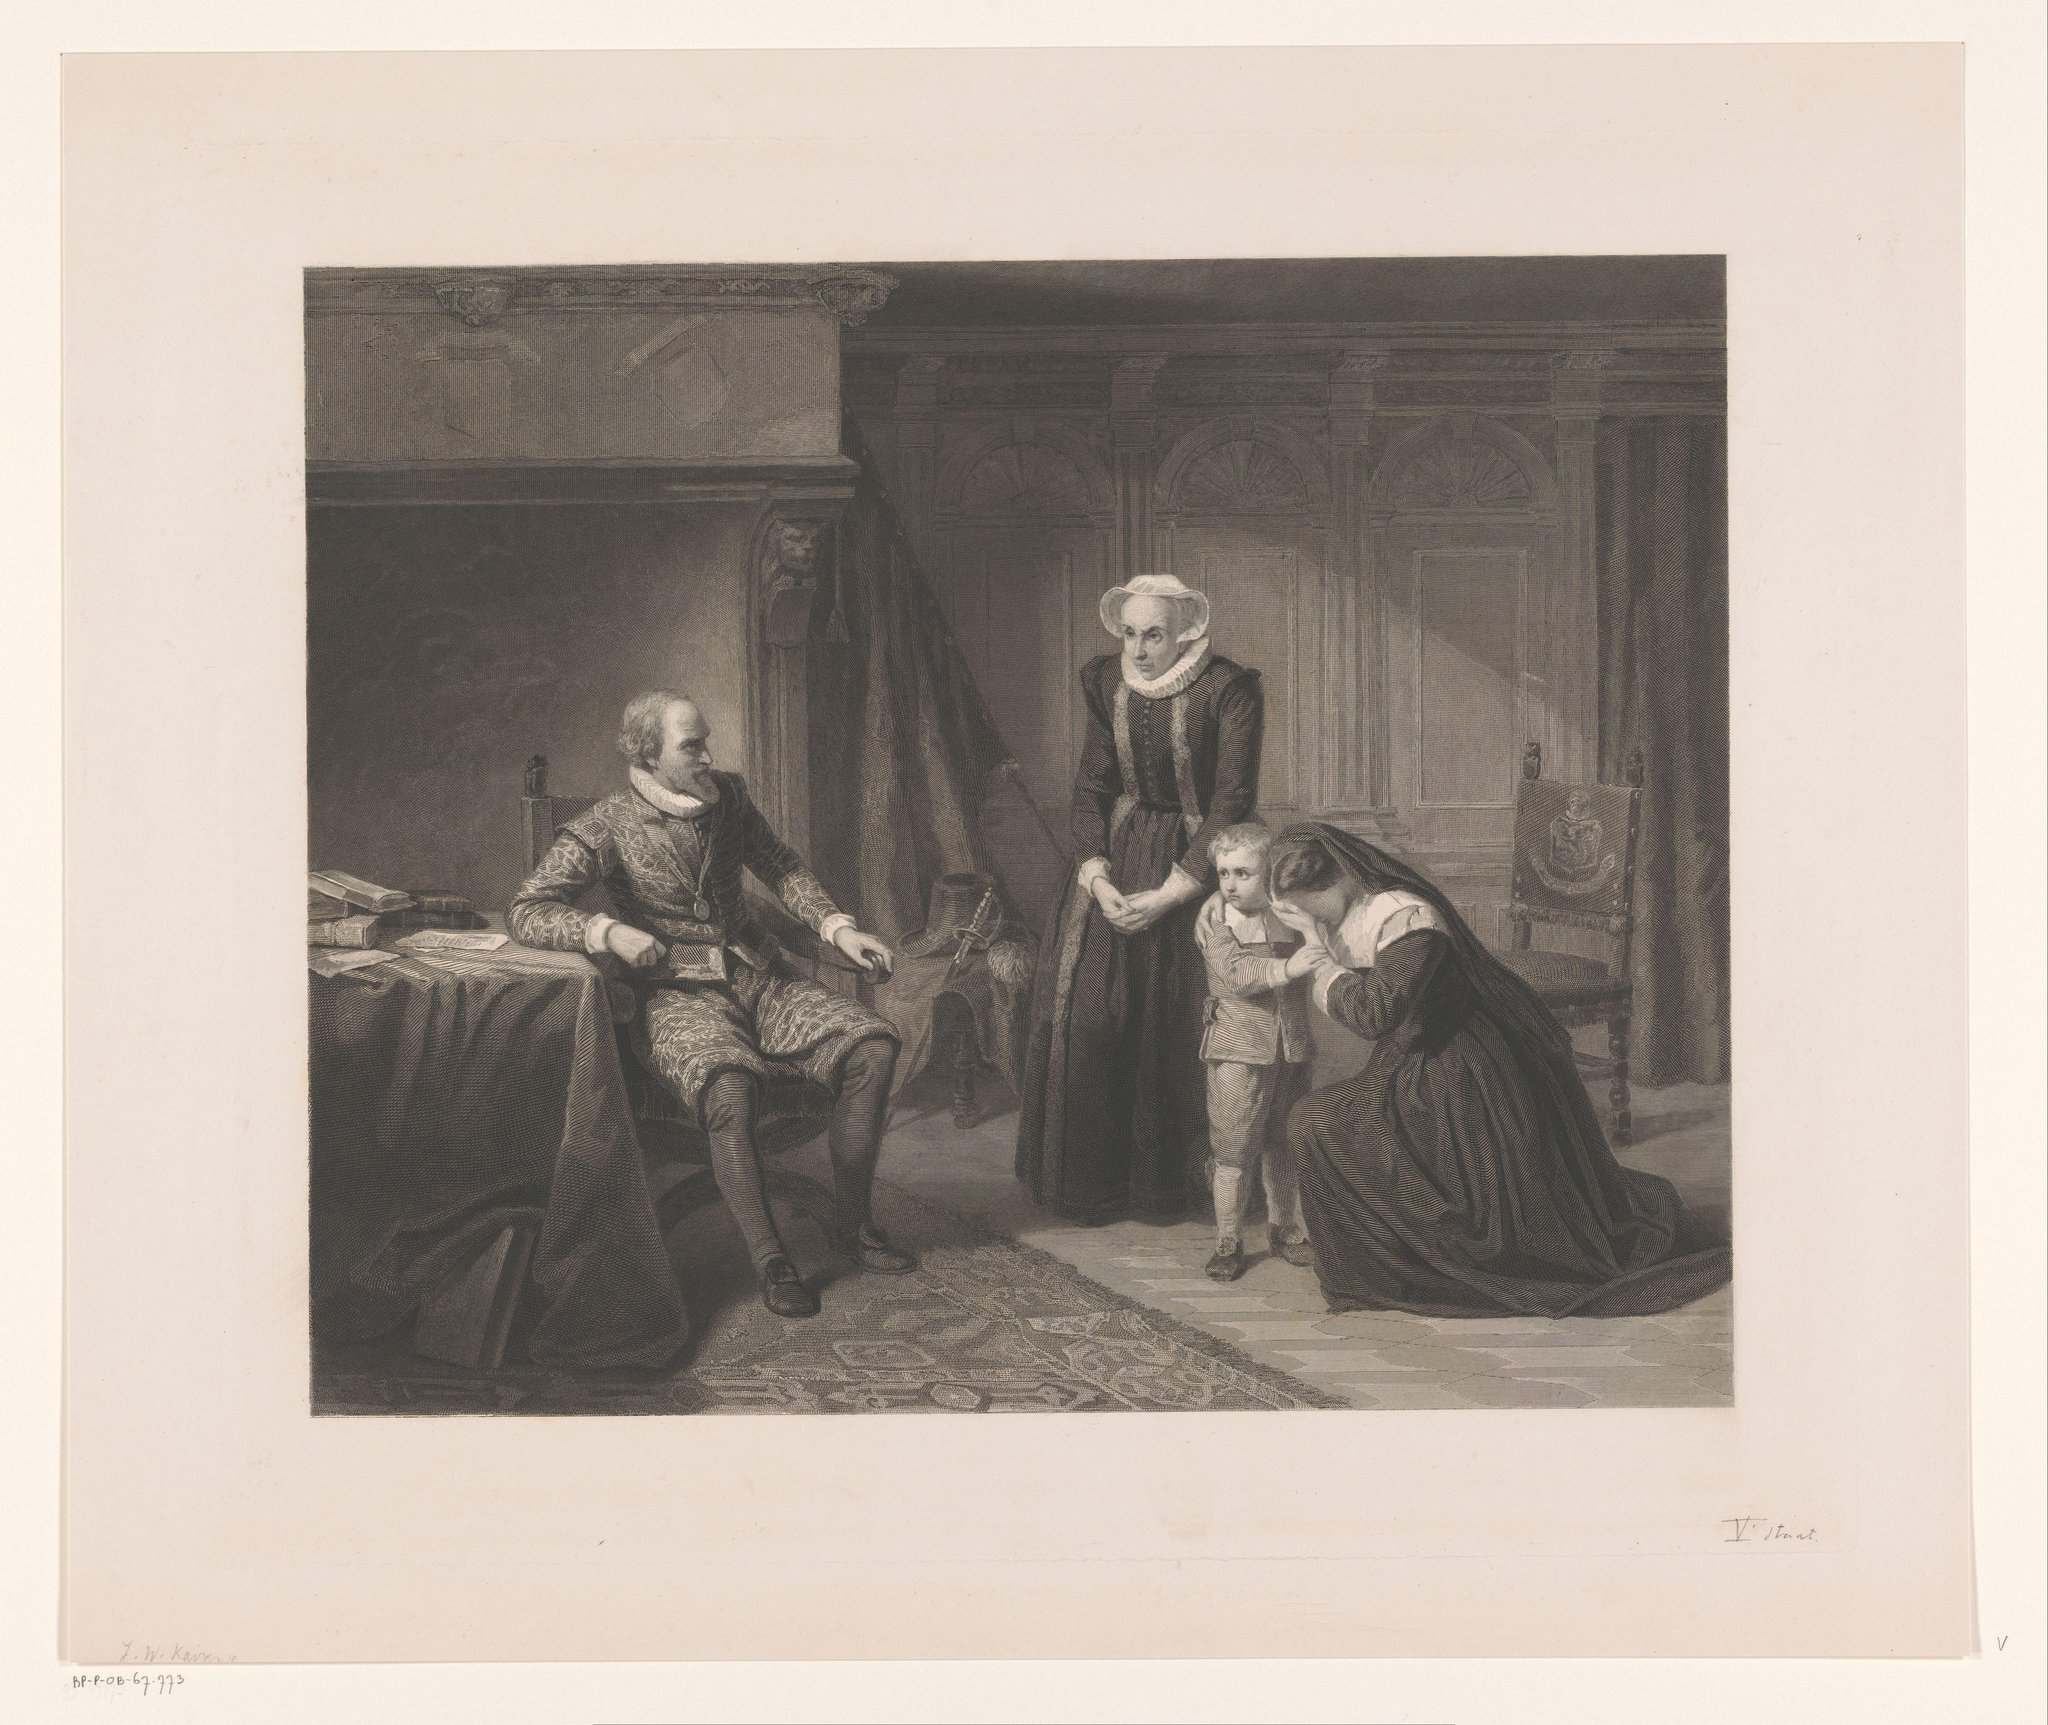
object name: print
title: De moeder, vrouw en zoon van Reinier van Oldenbarnevelt smeken Maurits om genade, 1623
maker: johann wilhelm kaiser (i)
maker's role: draughtsman, print maker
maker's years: 1813-1900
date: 1850-1899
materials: paper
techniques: roulette, engraving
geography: netherlands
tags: the hague, maurice (prince of orange)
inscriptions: collector's mark: Lugt 2166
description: De moeder, vrouw en zoon van Reinier van Oldenbarnevelt zitten bij prins Maurits aan een tafel en smeken om genade voor Reinier van Oldenbarnevelt, één van de ter dood veroordeelde samenzweerders, maart 1623.